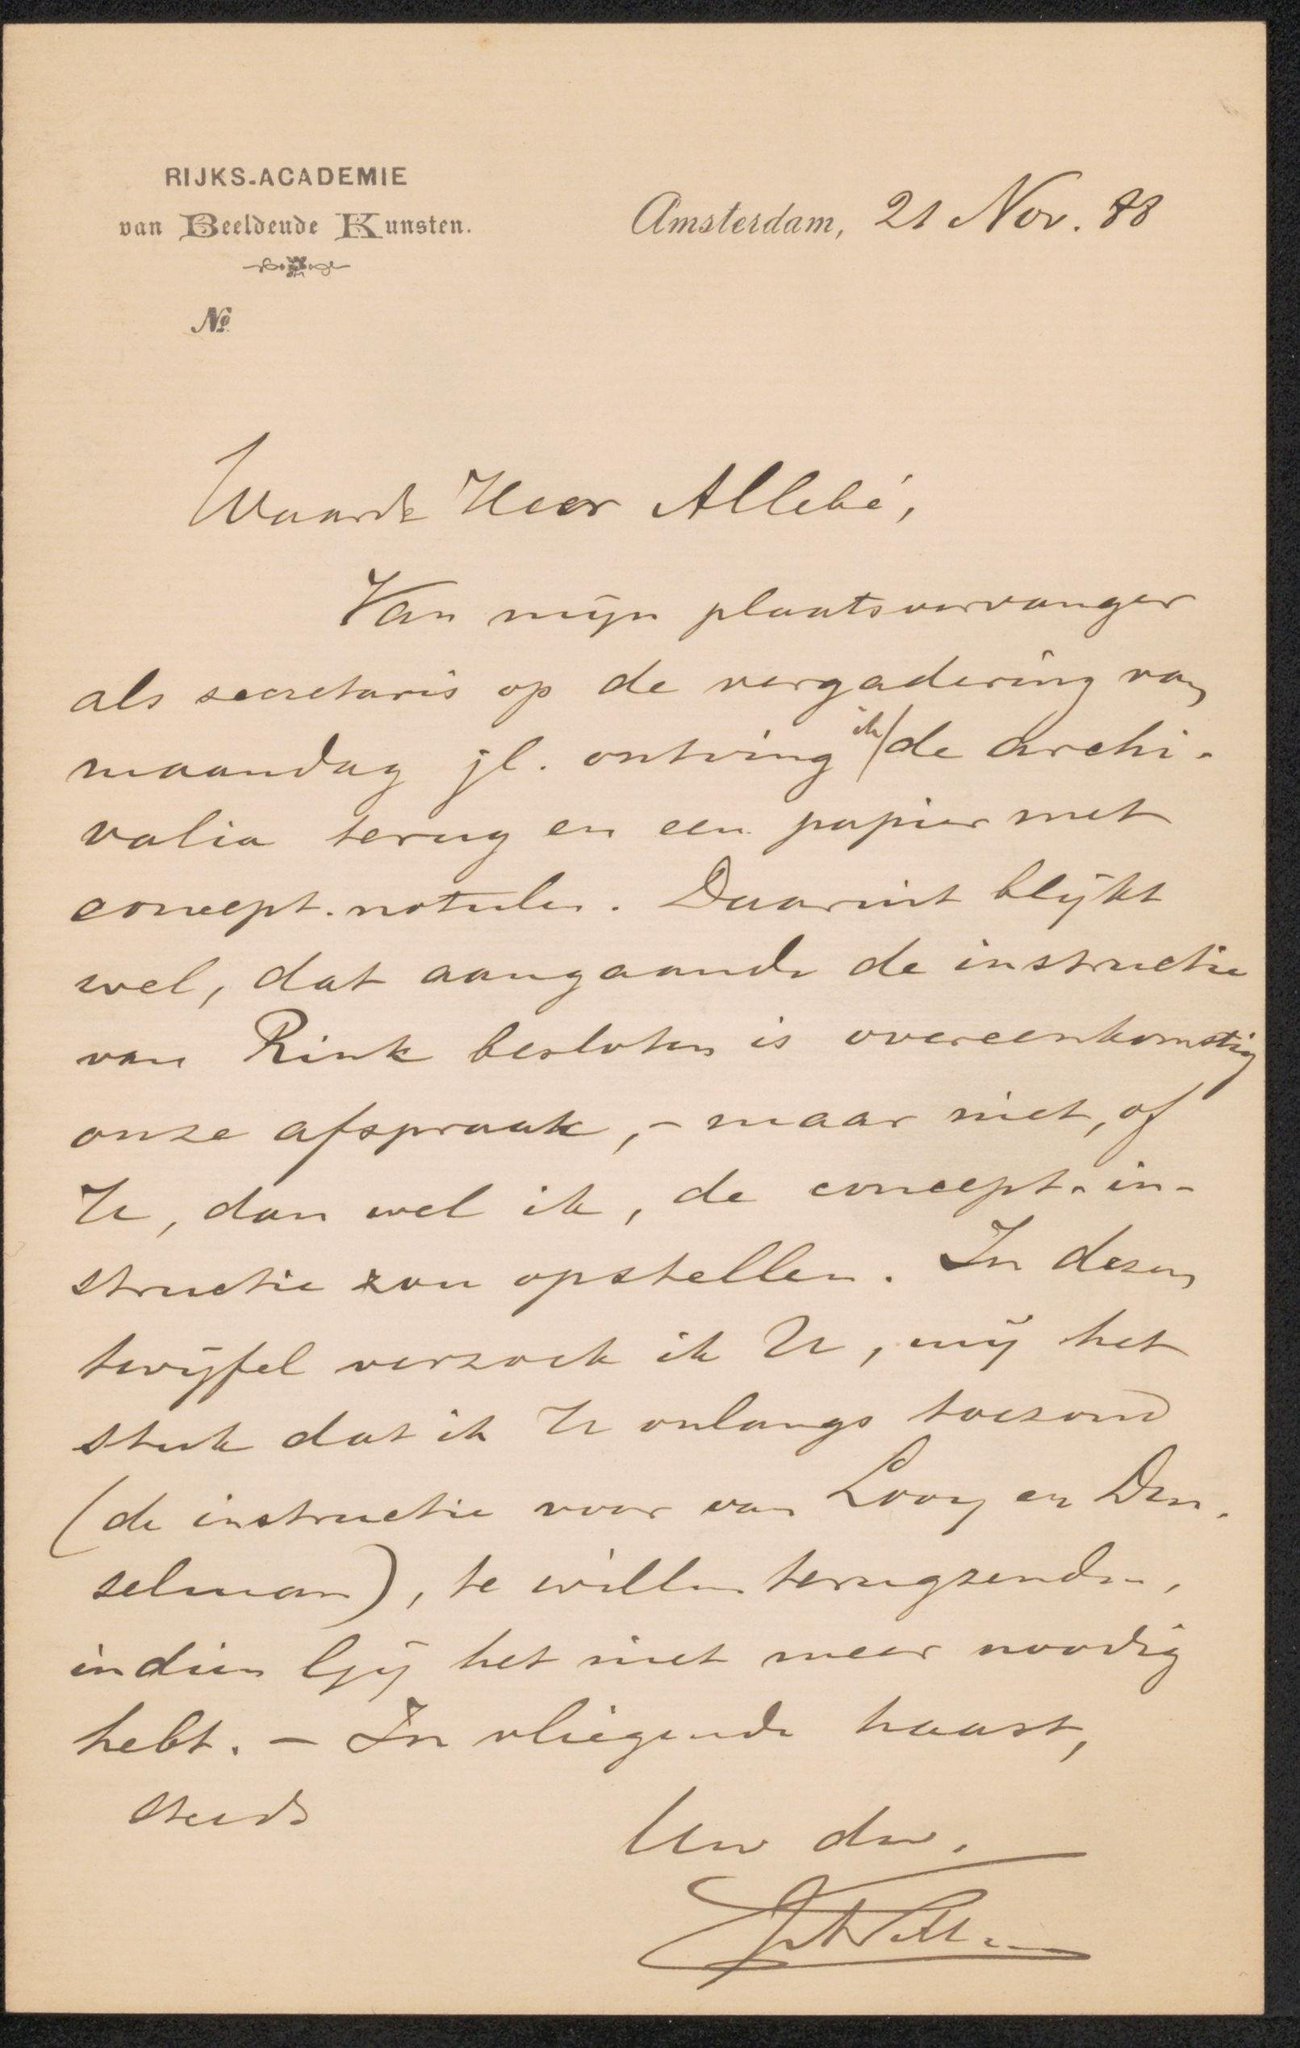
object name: letter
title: Brief aan August Allebé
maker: jérôme alexander sillem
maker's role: politician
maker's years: 1840-1912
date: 1888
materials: ink, paper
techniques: pen, printing, writing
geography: amsterdam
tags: august allebé, haarlem, painter, print maker, draughtsman, jac van looij, veghel, paul rink, den helder, amsterdam, jan dunselman, education, tuition of the artist (in general)